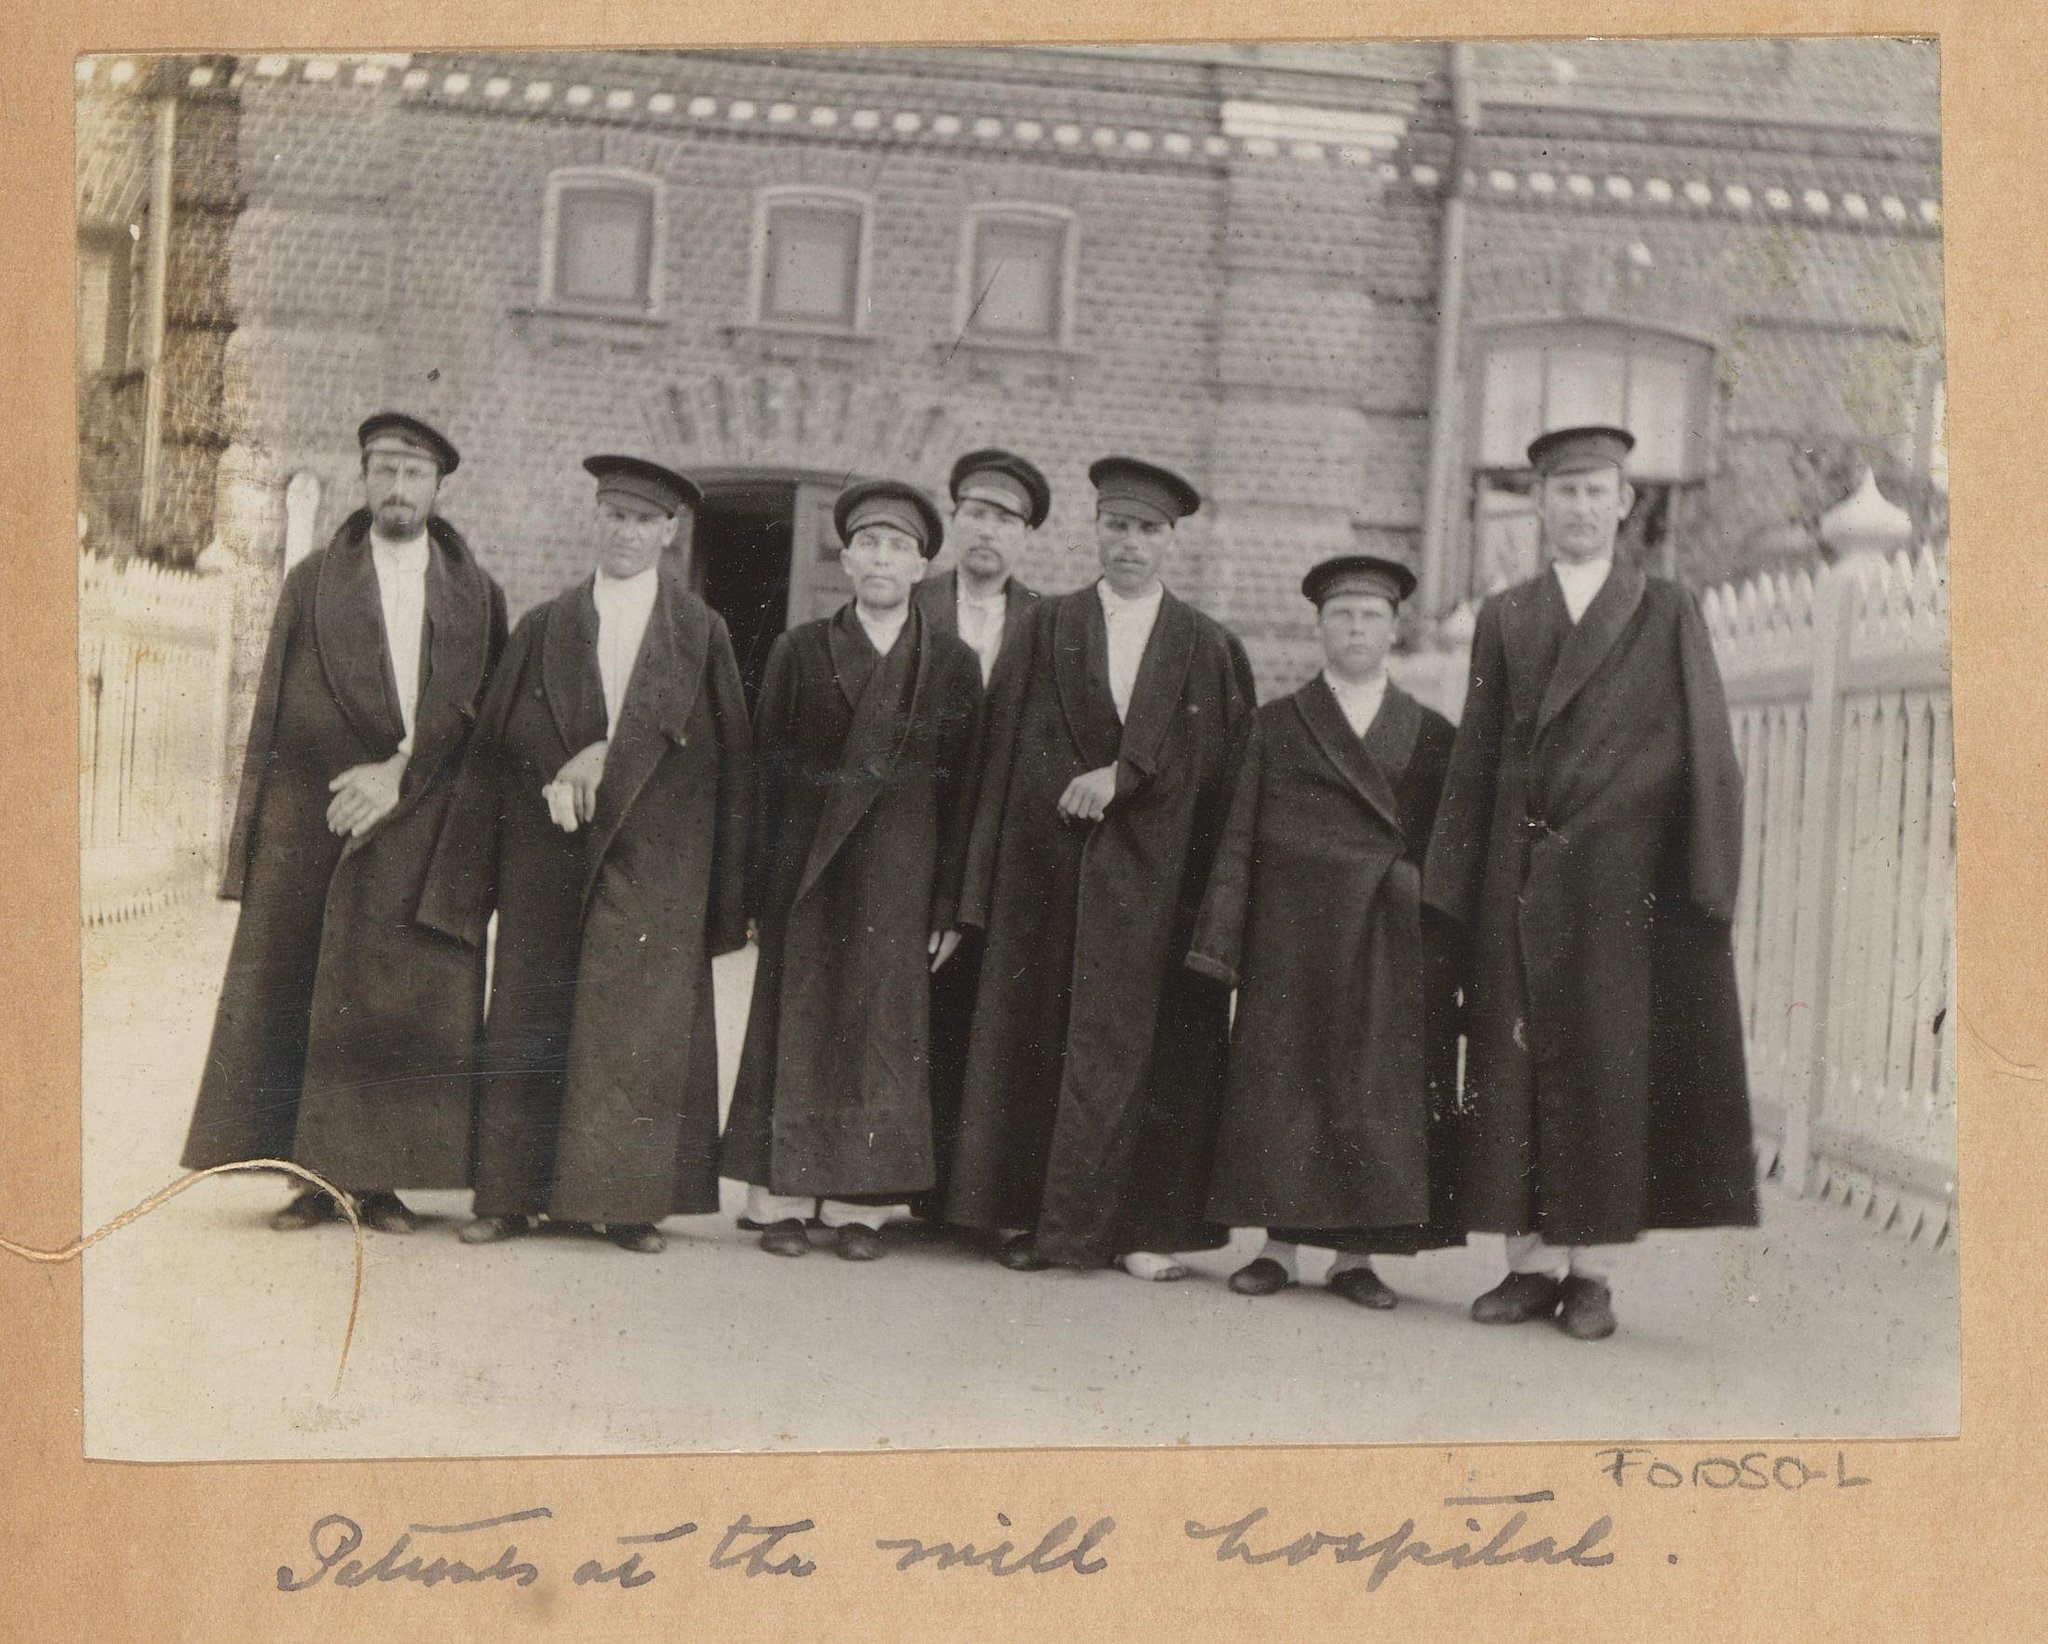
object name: photograph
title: Groep patiënten in lange jassen bij het fabrieksziekenhuis te Sereda in Rusland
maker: joseph cheetham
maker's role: engineer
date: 1903-1904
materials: photographic support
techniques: gelatin silver print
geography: russia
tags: hospital, patient, sick person, russia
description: Onderdeel van Fotoalbum van de Engelse familie Cheetham met opnames van hun verblijf in Rusland.